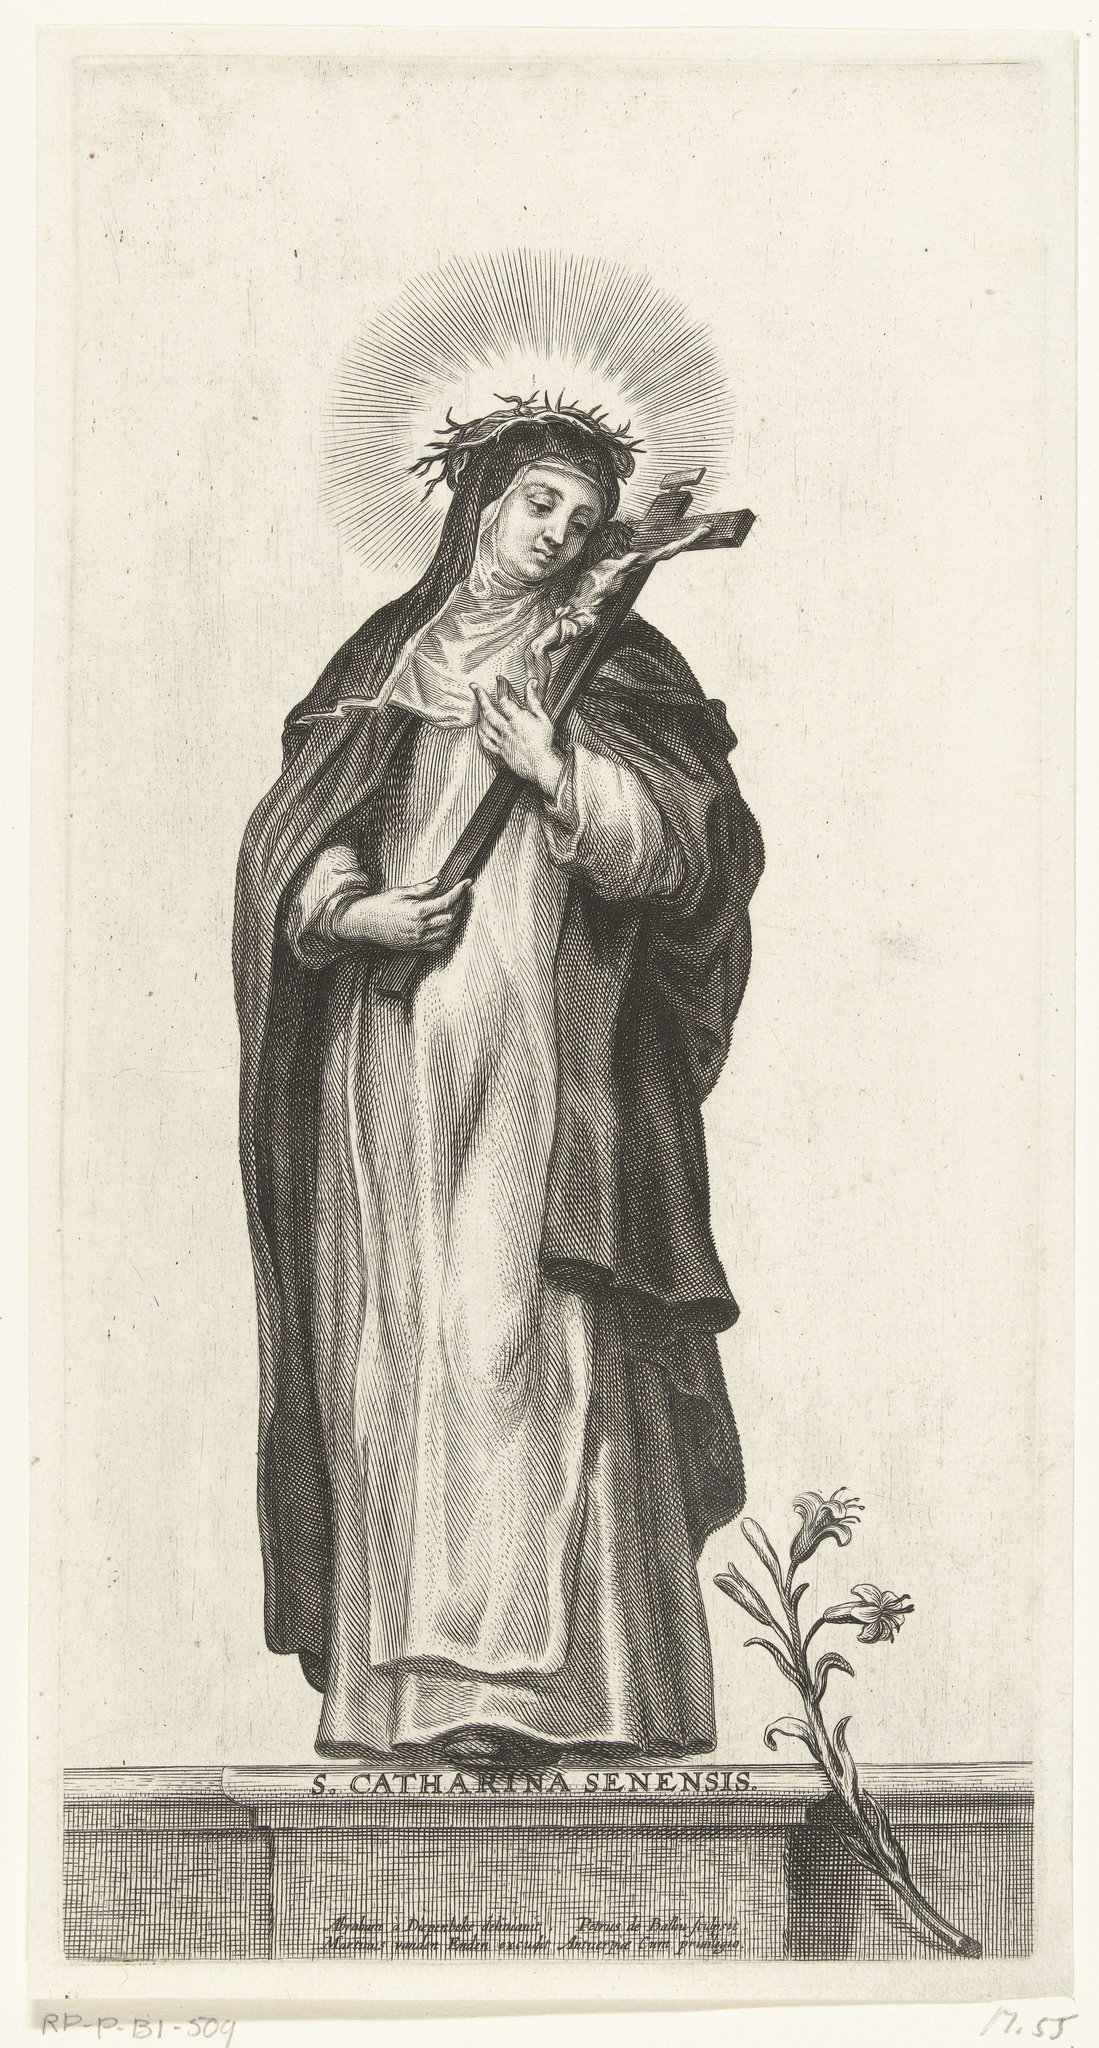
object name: print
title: Heilige Catharina van Siena met crucifix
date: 1623-1660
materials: paper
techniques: engraving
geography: antwerp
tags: the virgin and dominican tertiary, catherine of siena; possible attributes: book, cross, crown of thorns, crucifix, demon under foot, heart (with cross), lily, plague-stricken, ring, rosary, stigmata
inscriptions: collector's mark: Lugt 240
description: Prent naar tekeing van Abraham van Diepenbeeck.